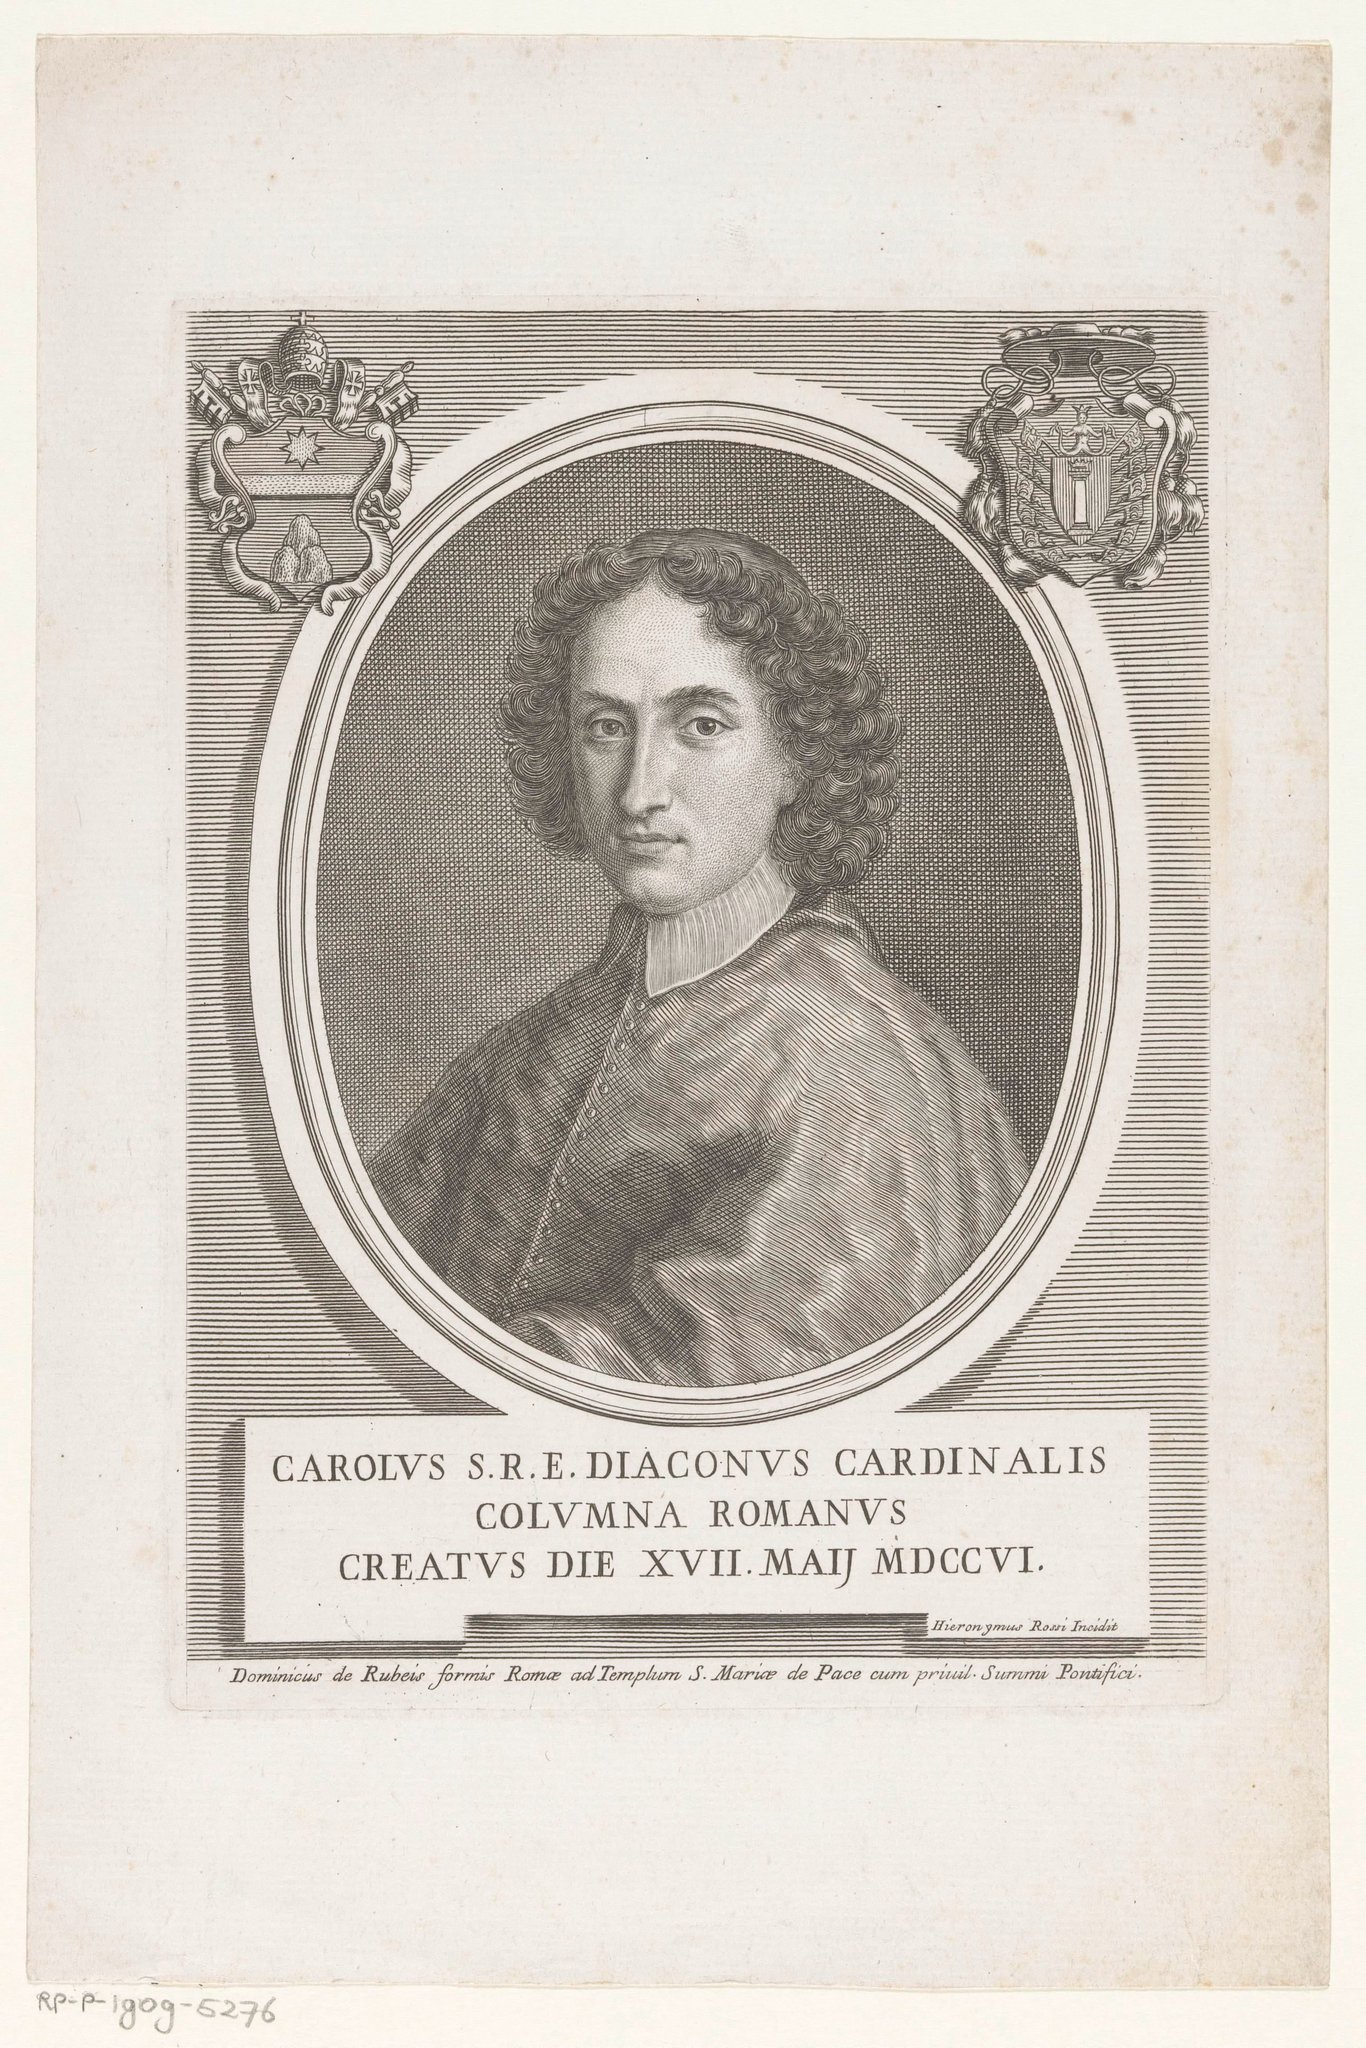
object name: print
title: Portret van kardinaal Carlo Colonna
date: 1706-1762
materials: paper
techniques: engraving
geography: rome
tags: rome, cardinal, historical persons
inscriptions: collector's mark: Lugt 2228